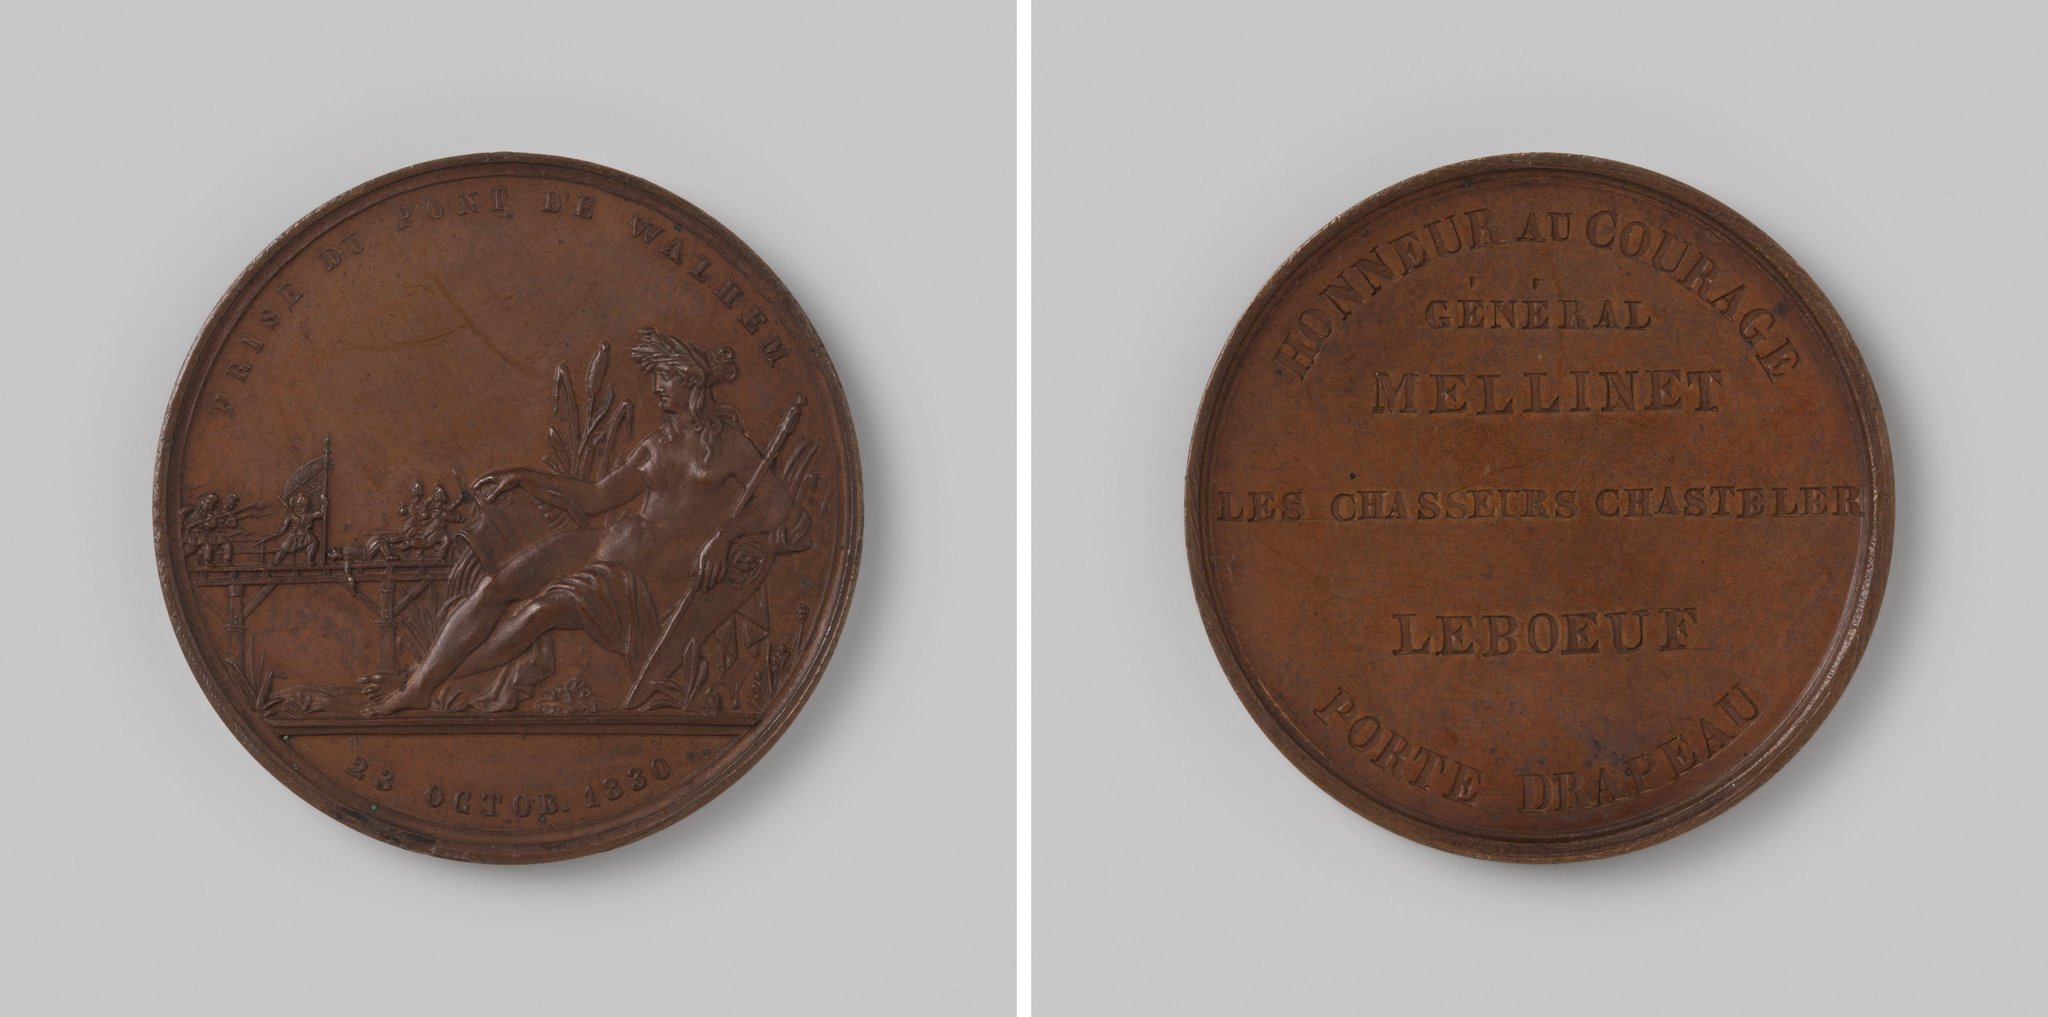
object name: history medal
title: Het nemen van de brug van Walhem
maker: joseph pierre braemt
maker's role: print maker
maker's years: 1796-1864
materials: bronze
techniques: striking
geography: brussels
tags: generaal, anne-francois mellinet, walem, inname van de brug van walem, belgische revolutie